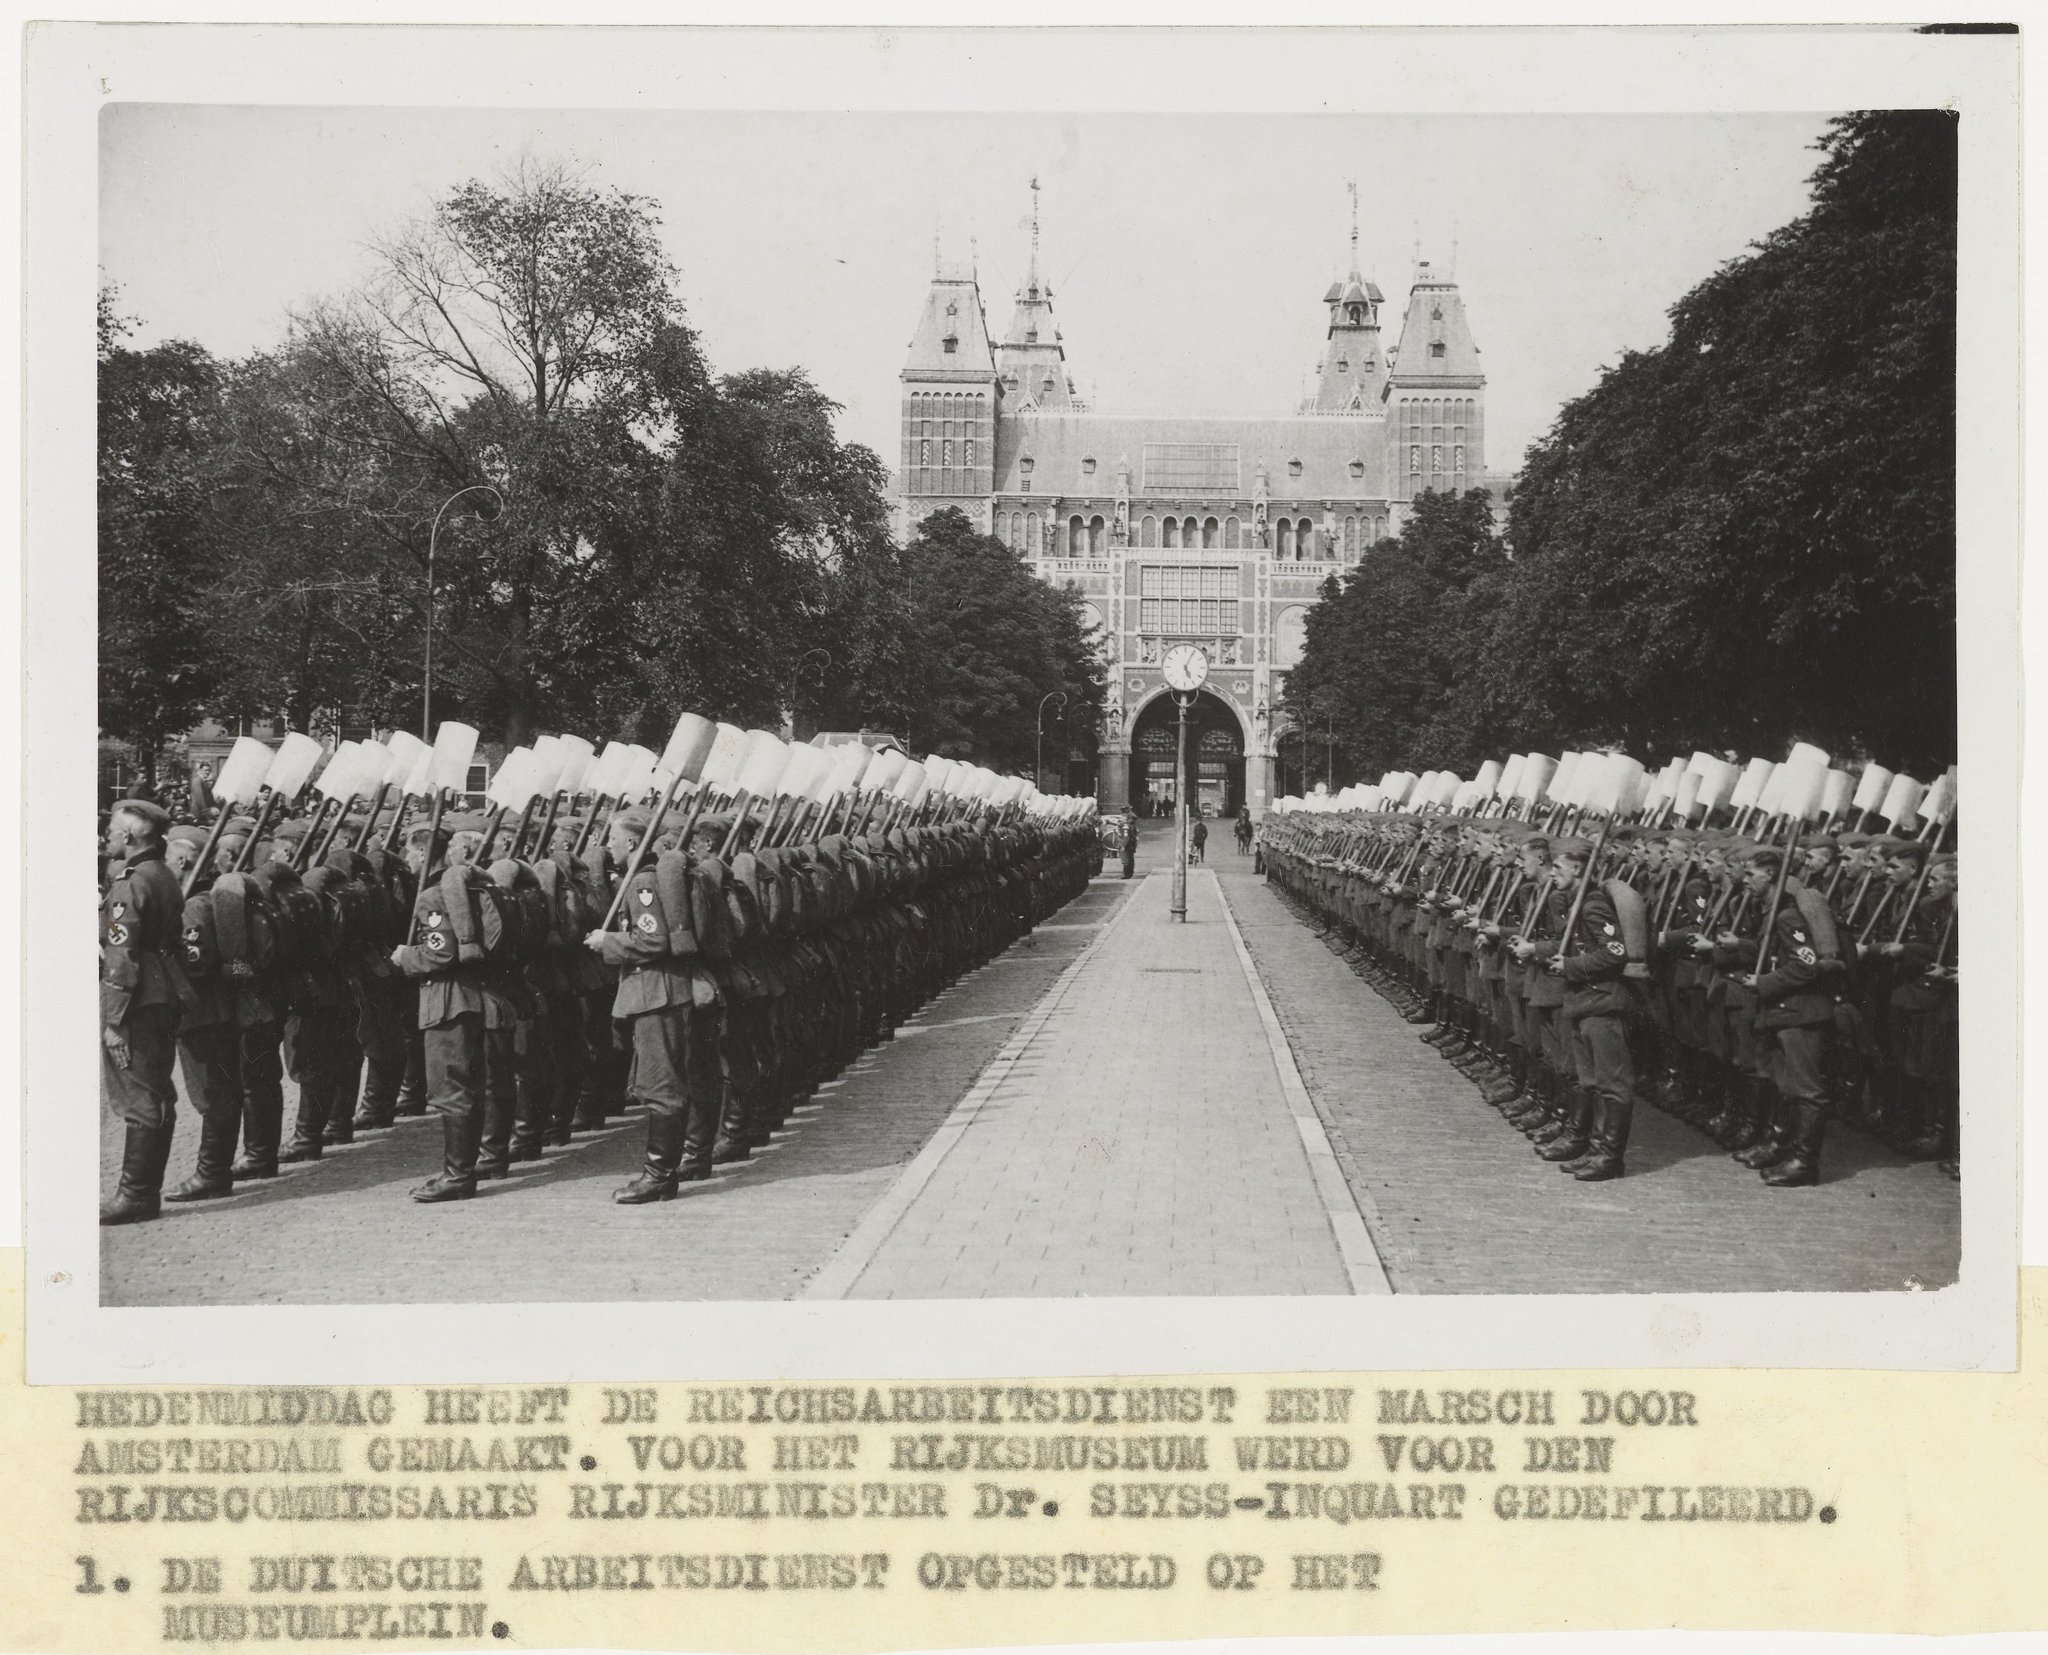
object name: photograph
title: Defilé van de Duitse Reichsarbeitsdienst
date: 1940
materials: photographic support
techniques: photography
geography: museumplein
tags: arthur seyss-inquart, rijksmuseum amsterdam, military parade, pageant, amsterdam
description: Voor het Rijksmuseum houdt de Duitse Reichsarbeitsdienst een defilé voor Seyss Inquart. Tekststrookje aan foto geplakt.